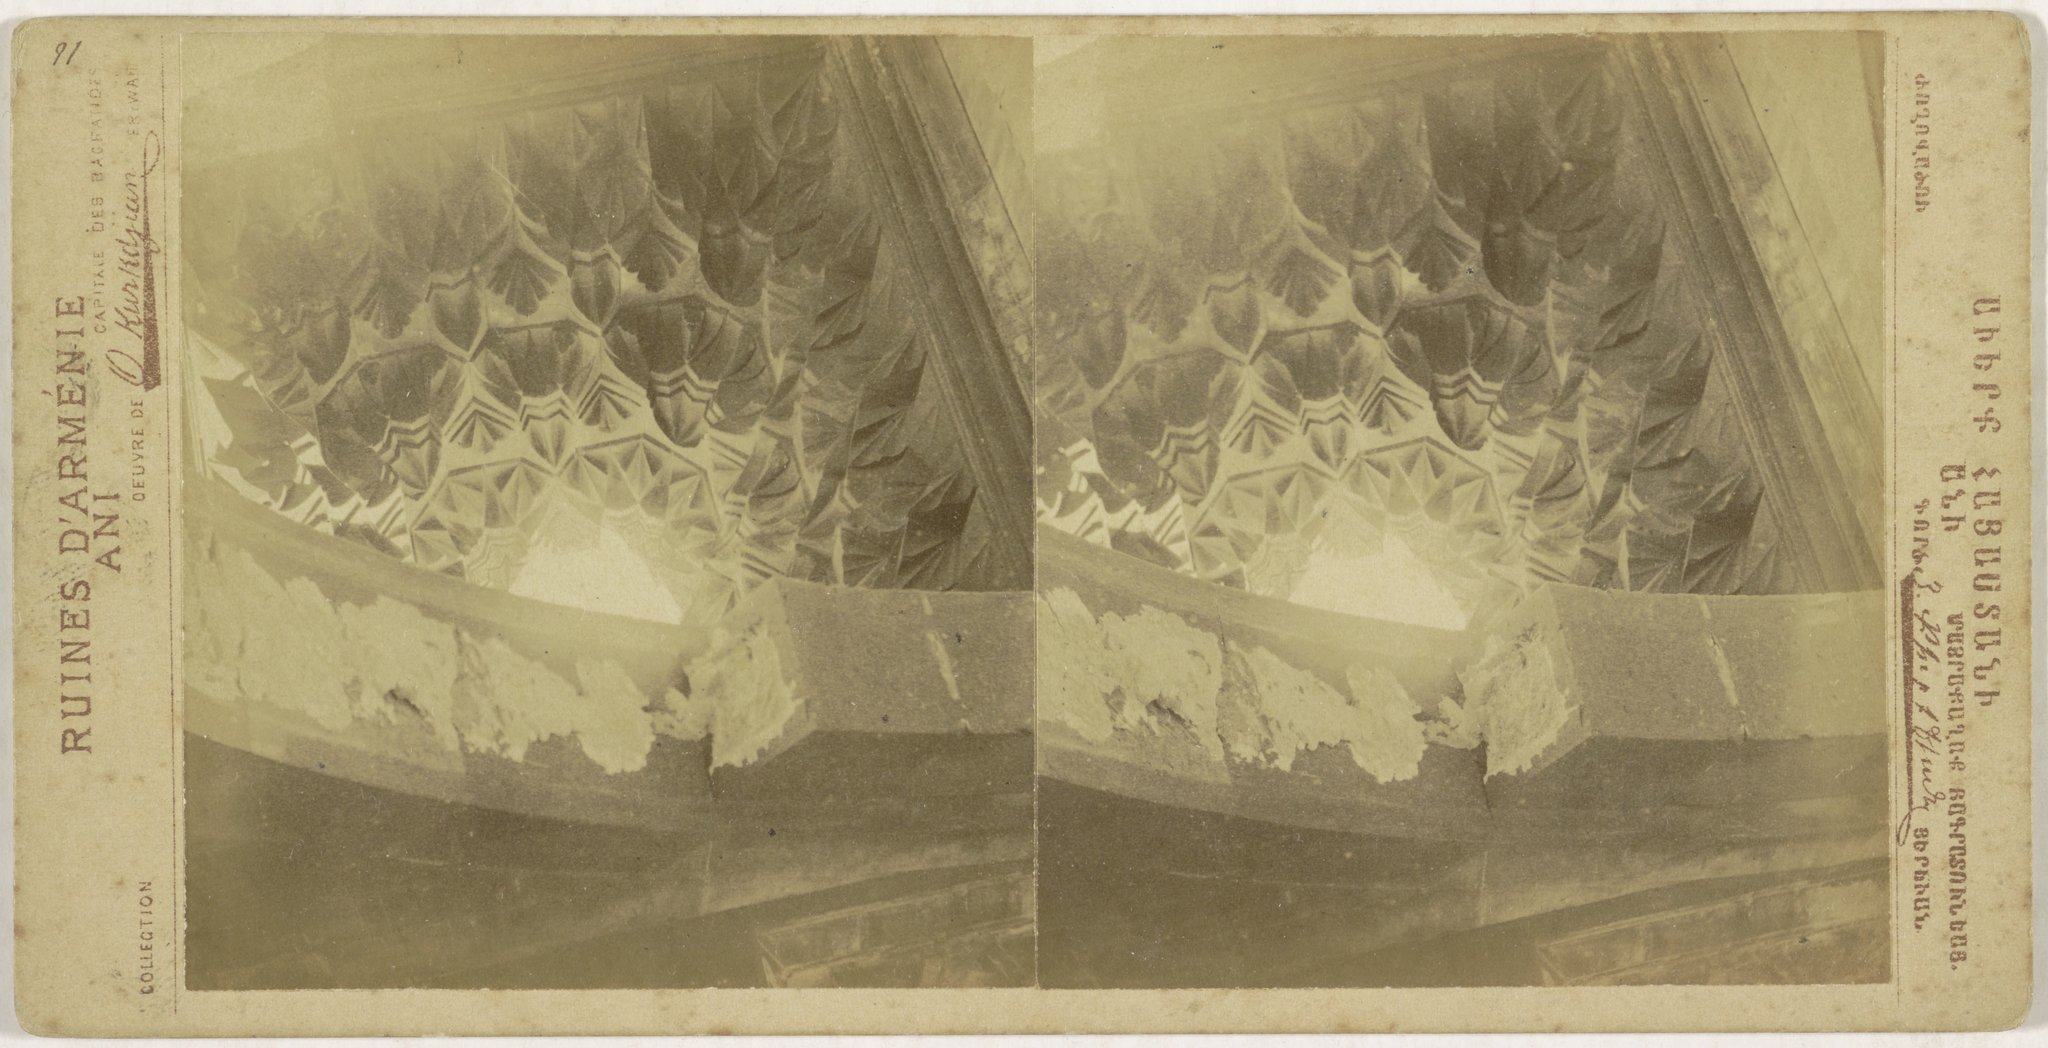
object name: stereograph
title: Plafond van de Kerk van de Apostelen, Ani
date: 1875-1880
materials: cardboard, paper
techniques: albumen print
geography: ocaklı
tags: ruin of a building ~ architecture, (decorated) ceiling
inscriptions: inscription: ‘Collection Oeuvre de O. Kurkdjian Eriwan’, inscription: ‘Tous droits résérvés.’, number: ‘16’